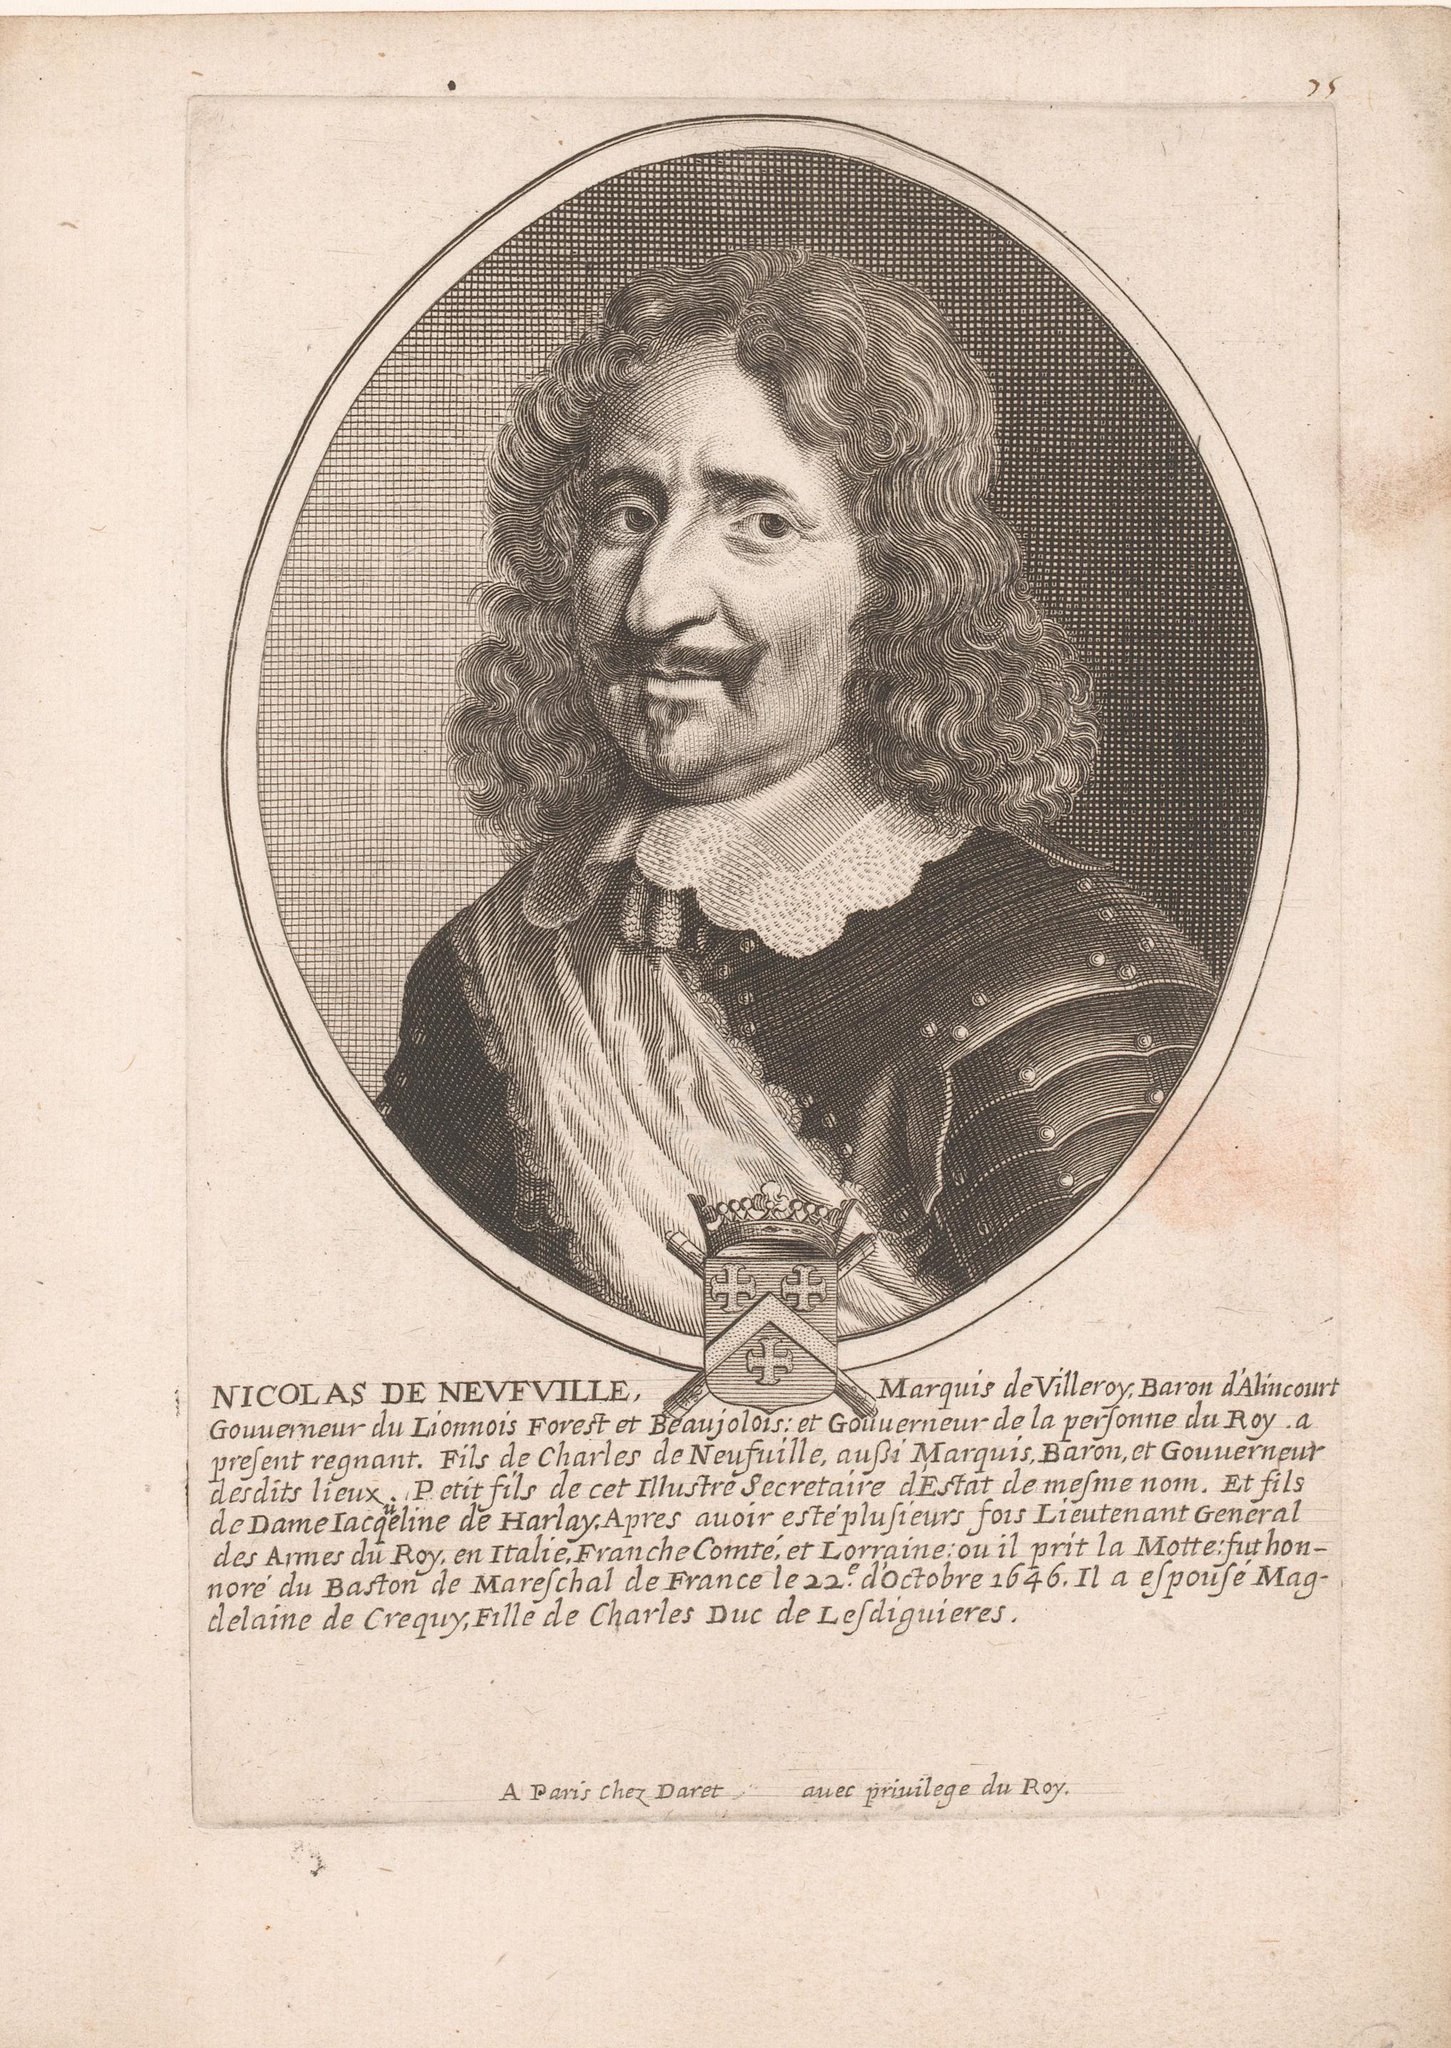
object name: print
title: Tableaux historiques ou sont gravez les Illustres François et Etrangiers de l'un et l'autre sexe (...)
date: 1652-1656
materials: paper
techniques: engraving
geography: paris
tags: historical persons, armorial bearing, heraldry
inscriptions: number: ‘55’, collector's mark: Lugt 2228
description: Maakt deel uit van een serie portretten getiteld 'Tableaux historiques ou sont gravez les Illustres François et Etrangiers de l'un et l'autre sexe (...)', voor het eerst uitgegeven in 1652 door Daret. Een tweede staat werd uitgegeven door Boissevin en een derde door Jollain.